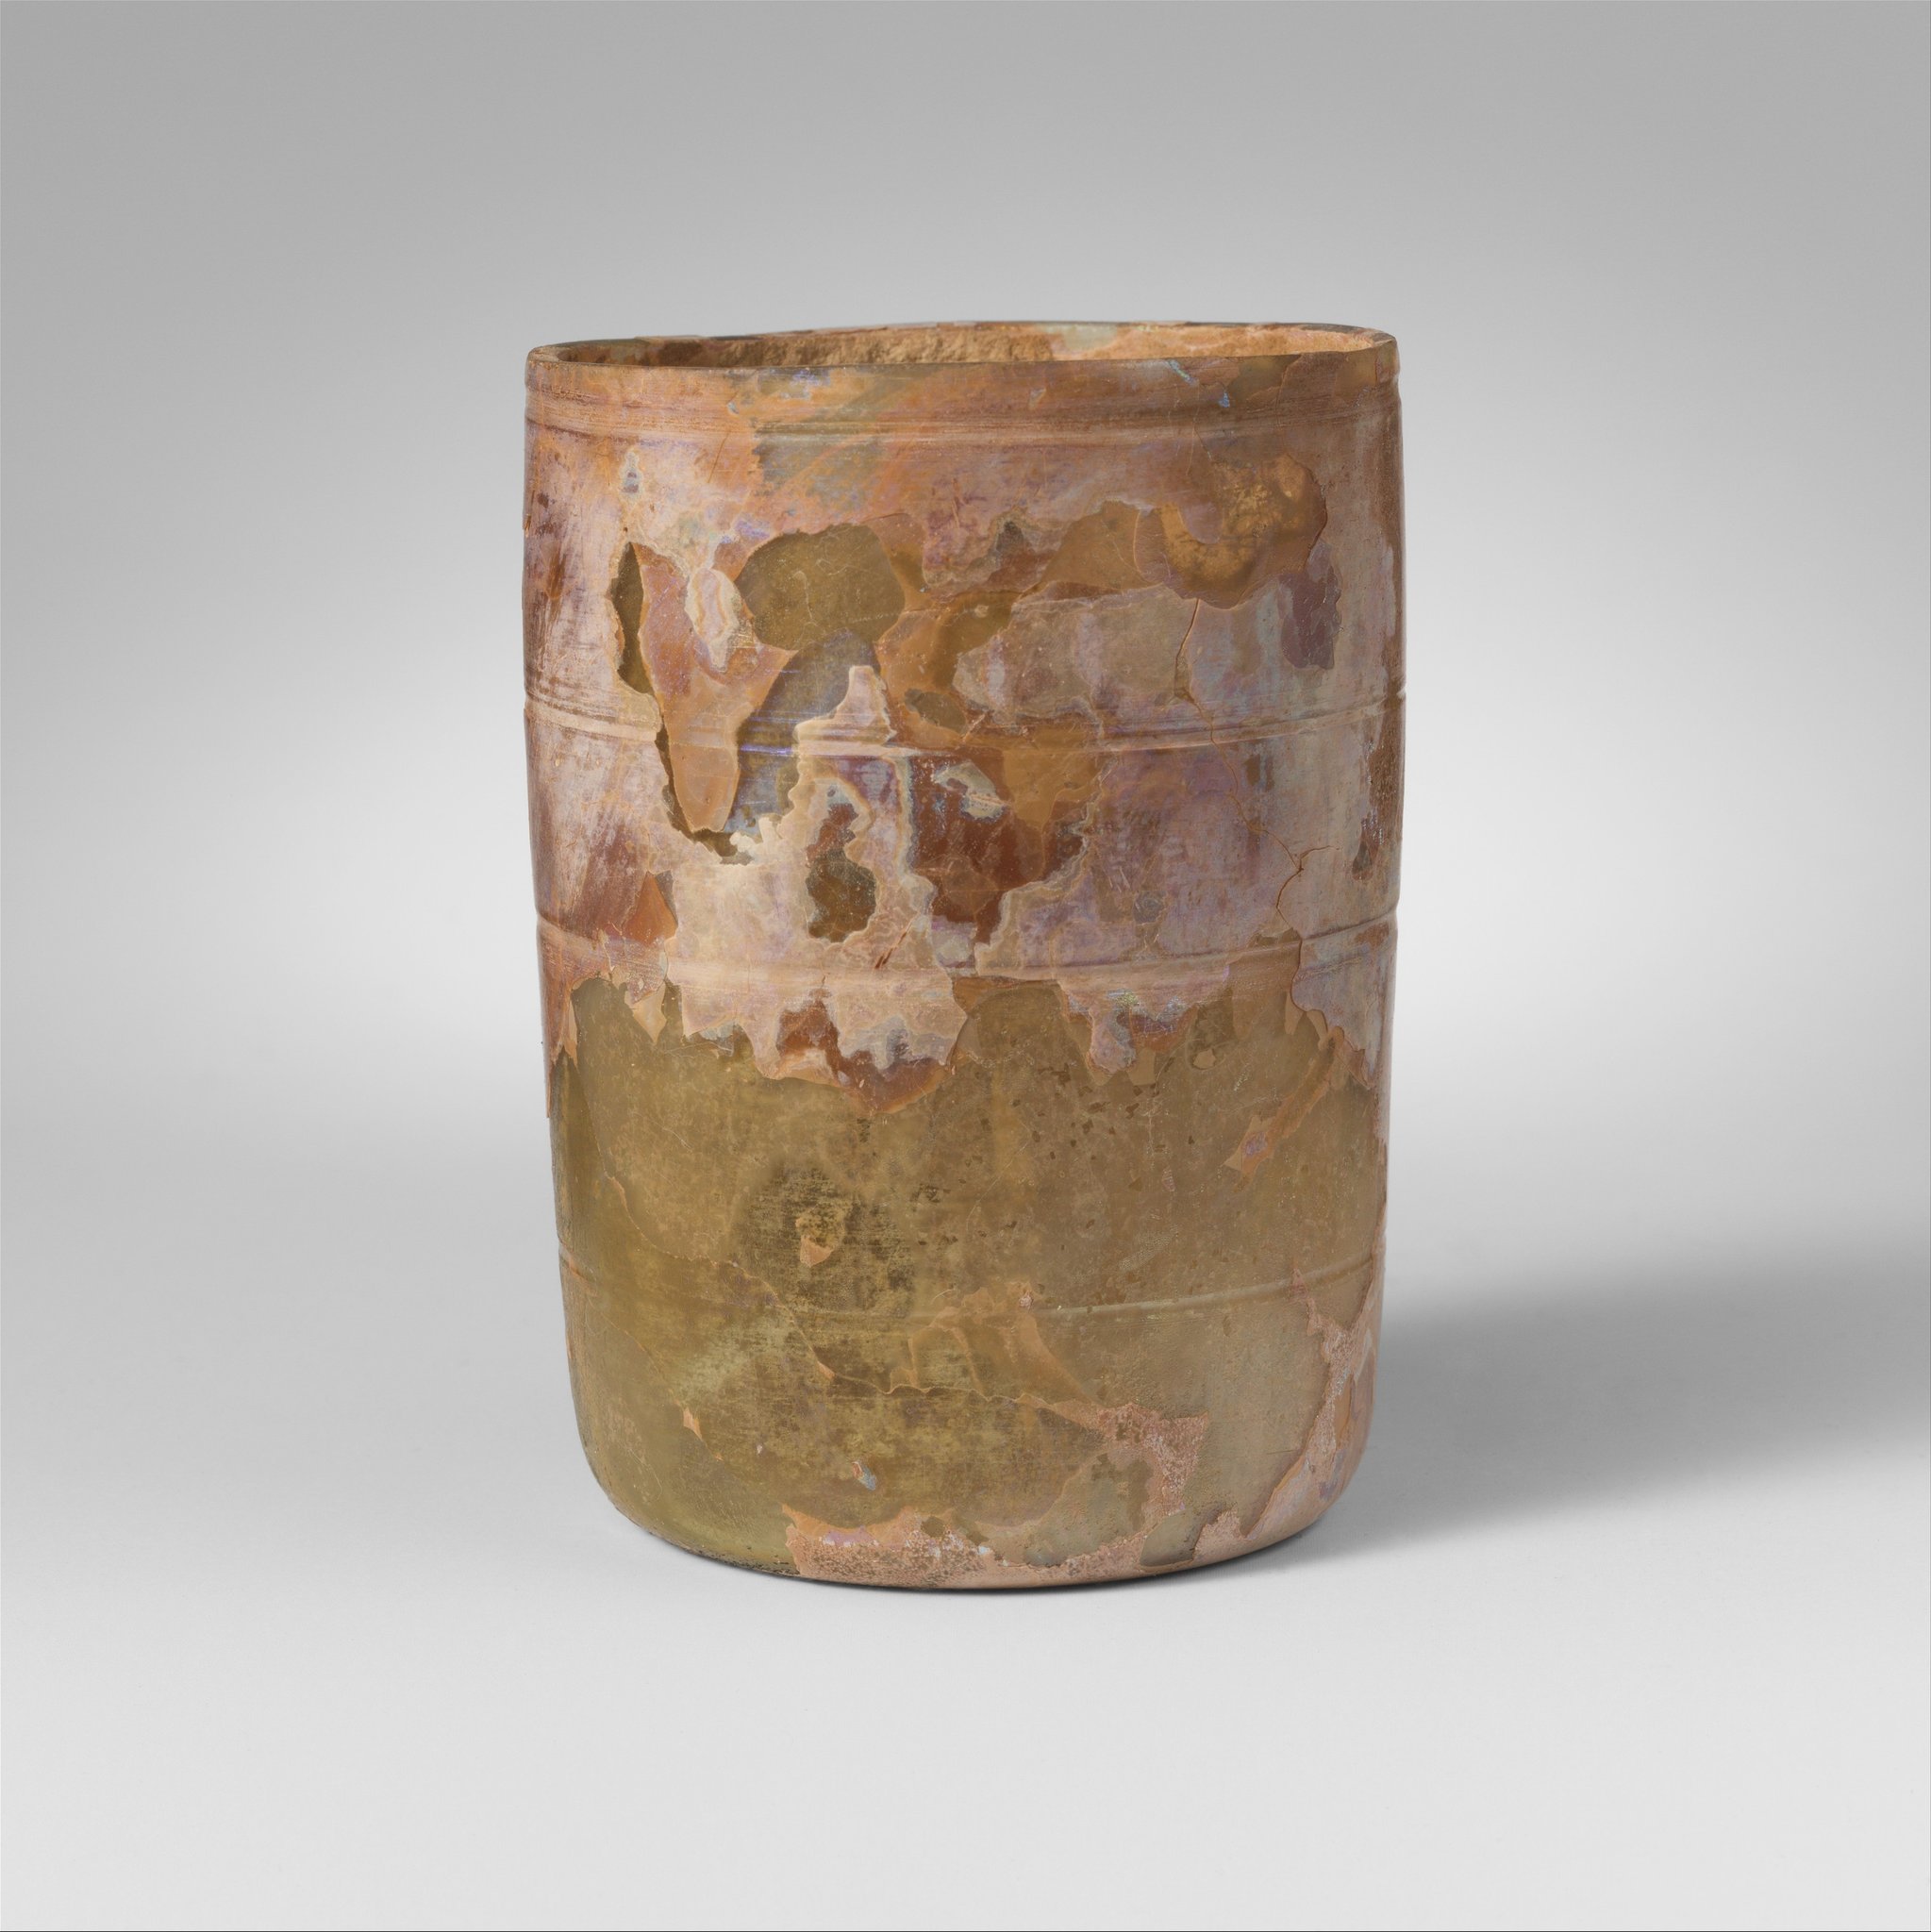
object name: beaker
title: Glass beaker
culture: roman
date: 1-100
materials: glass